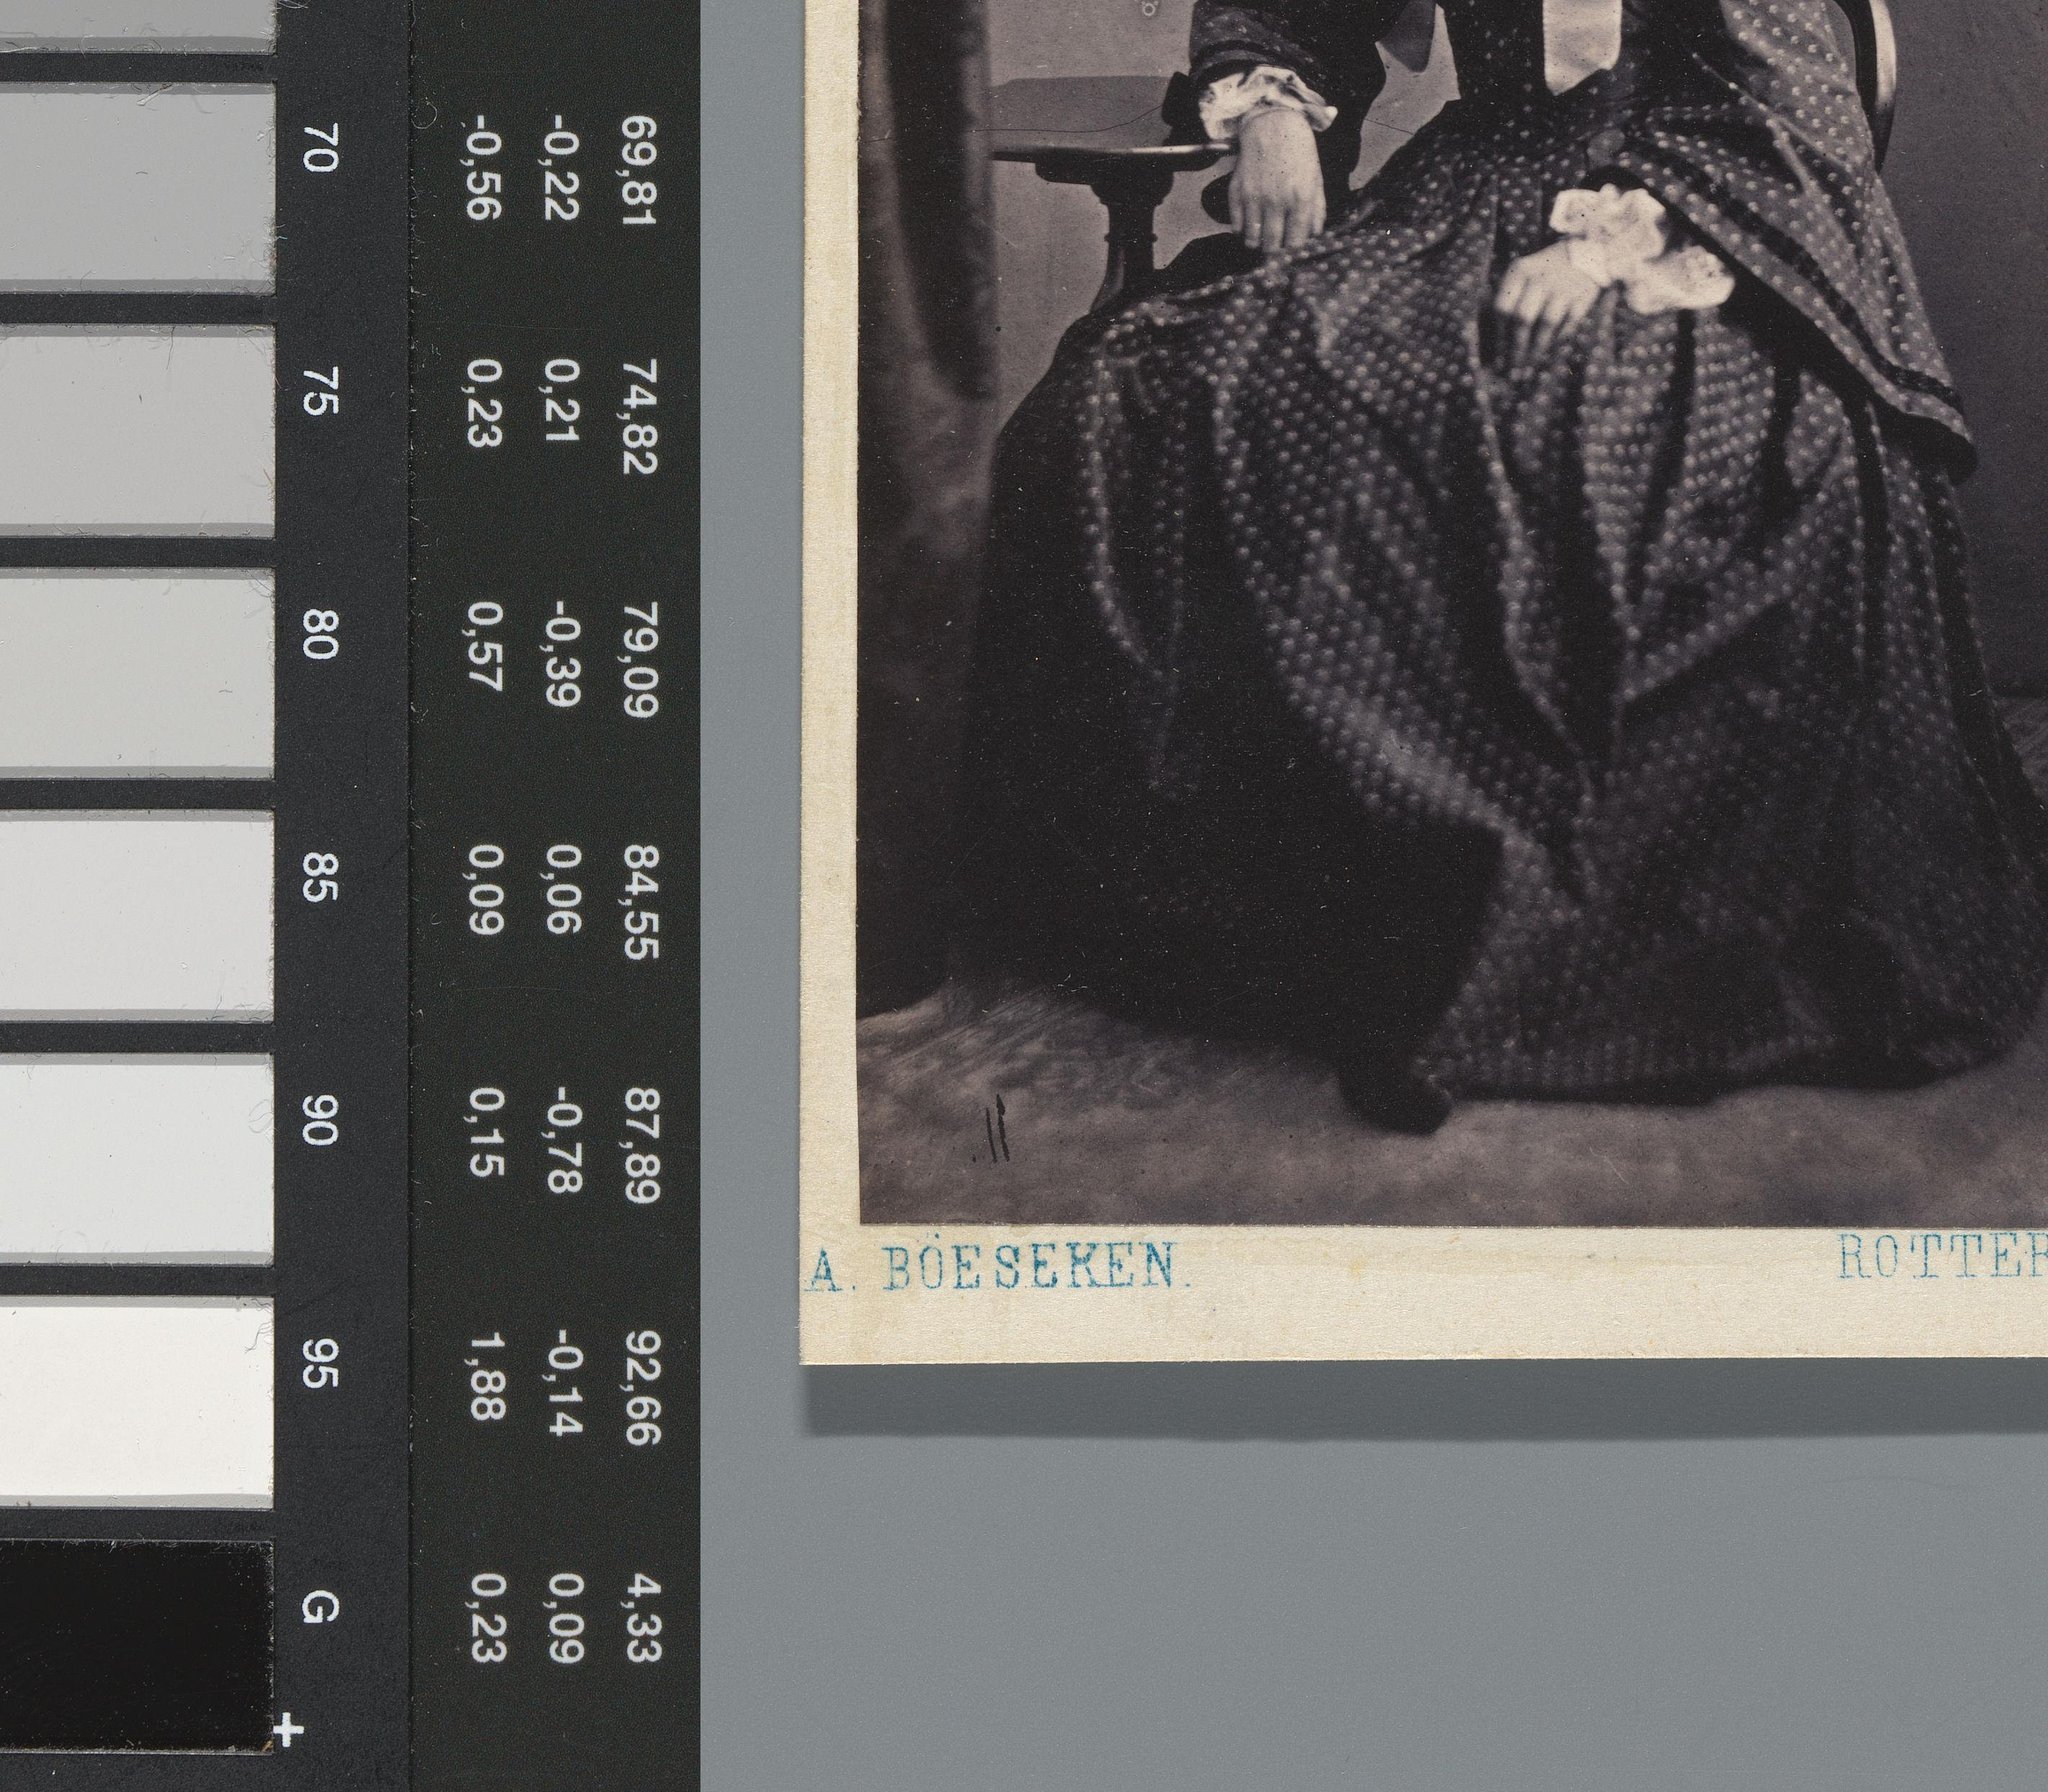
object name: carte de visite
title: Portret van Emilia Maria Theresia van Kerckhoff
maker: a. böeseken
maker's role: fotograaf, lithograaf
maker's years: 1834-1919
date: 1855-1910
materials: cardboard, photographic support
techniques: albumen print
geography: rotterdam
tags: rotterdam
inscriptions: address: ‘Photographisch Atelier / A. BÖESKEN / Hoogstraat over de Vlasmarkt / ROTTERDAM.’